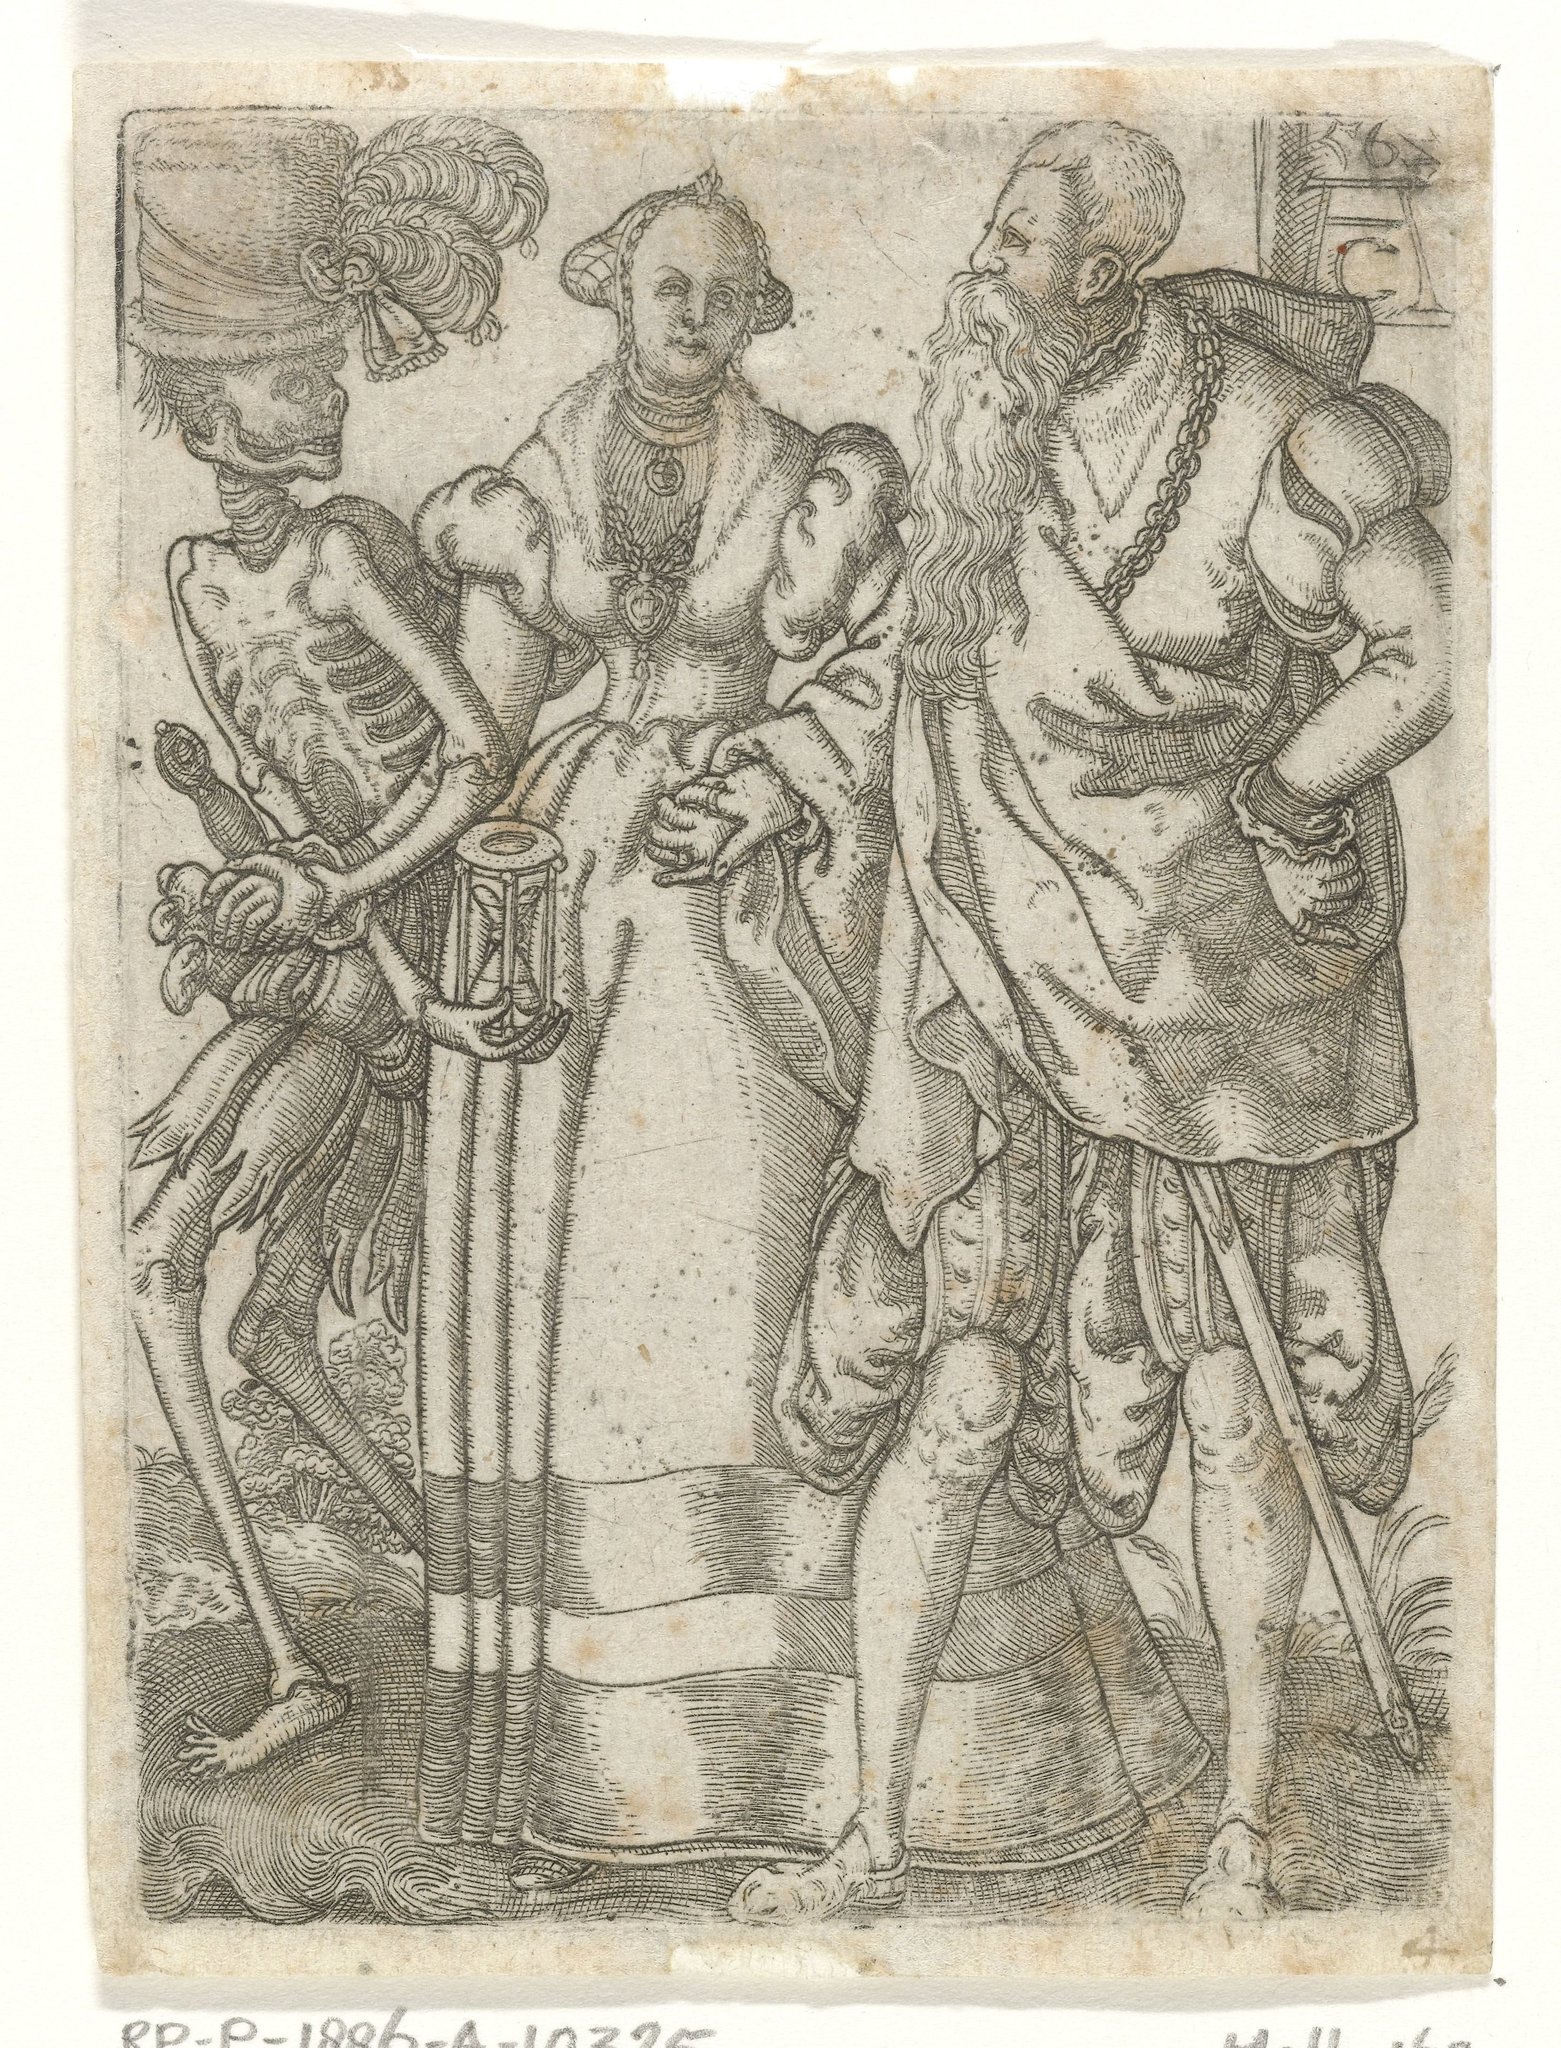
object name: print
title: Dodendans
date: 1562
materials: paper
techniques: engraving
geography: low countries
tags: dance of death; death together with one or more human beings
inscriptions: collector's mark: Lugt 2228